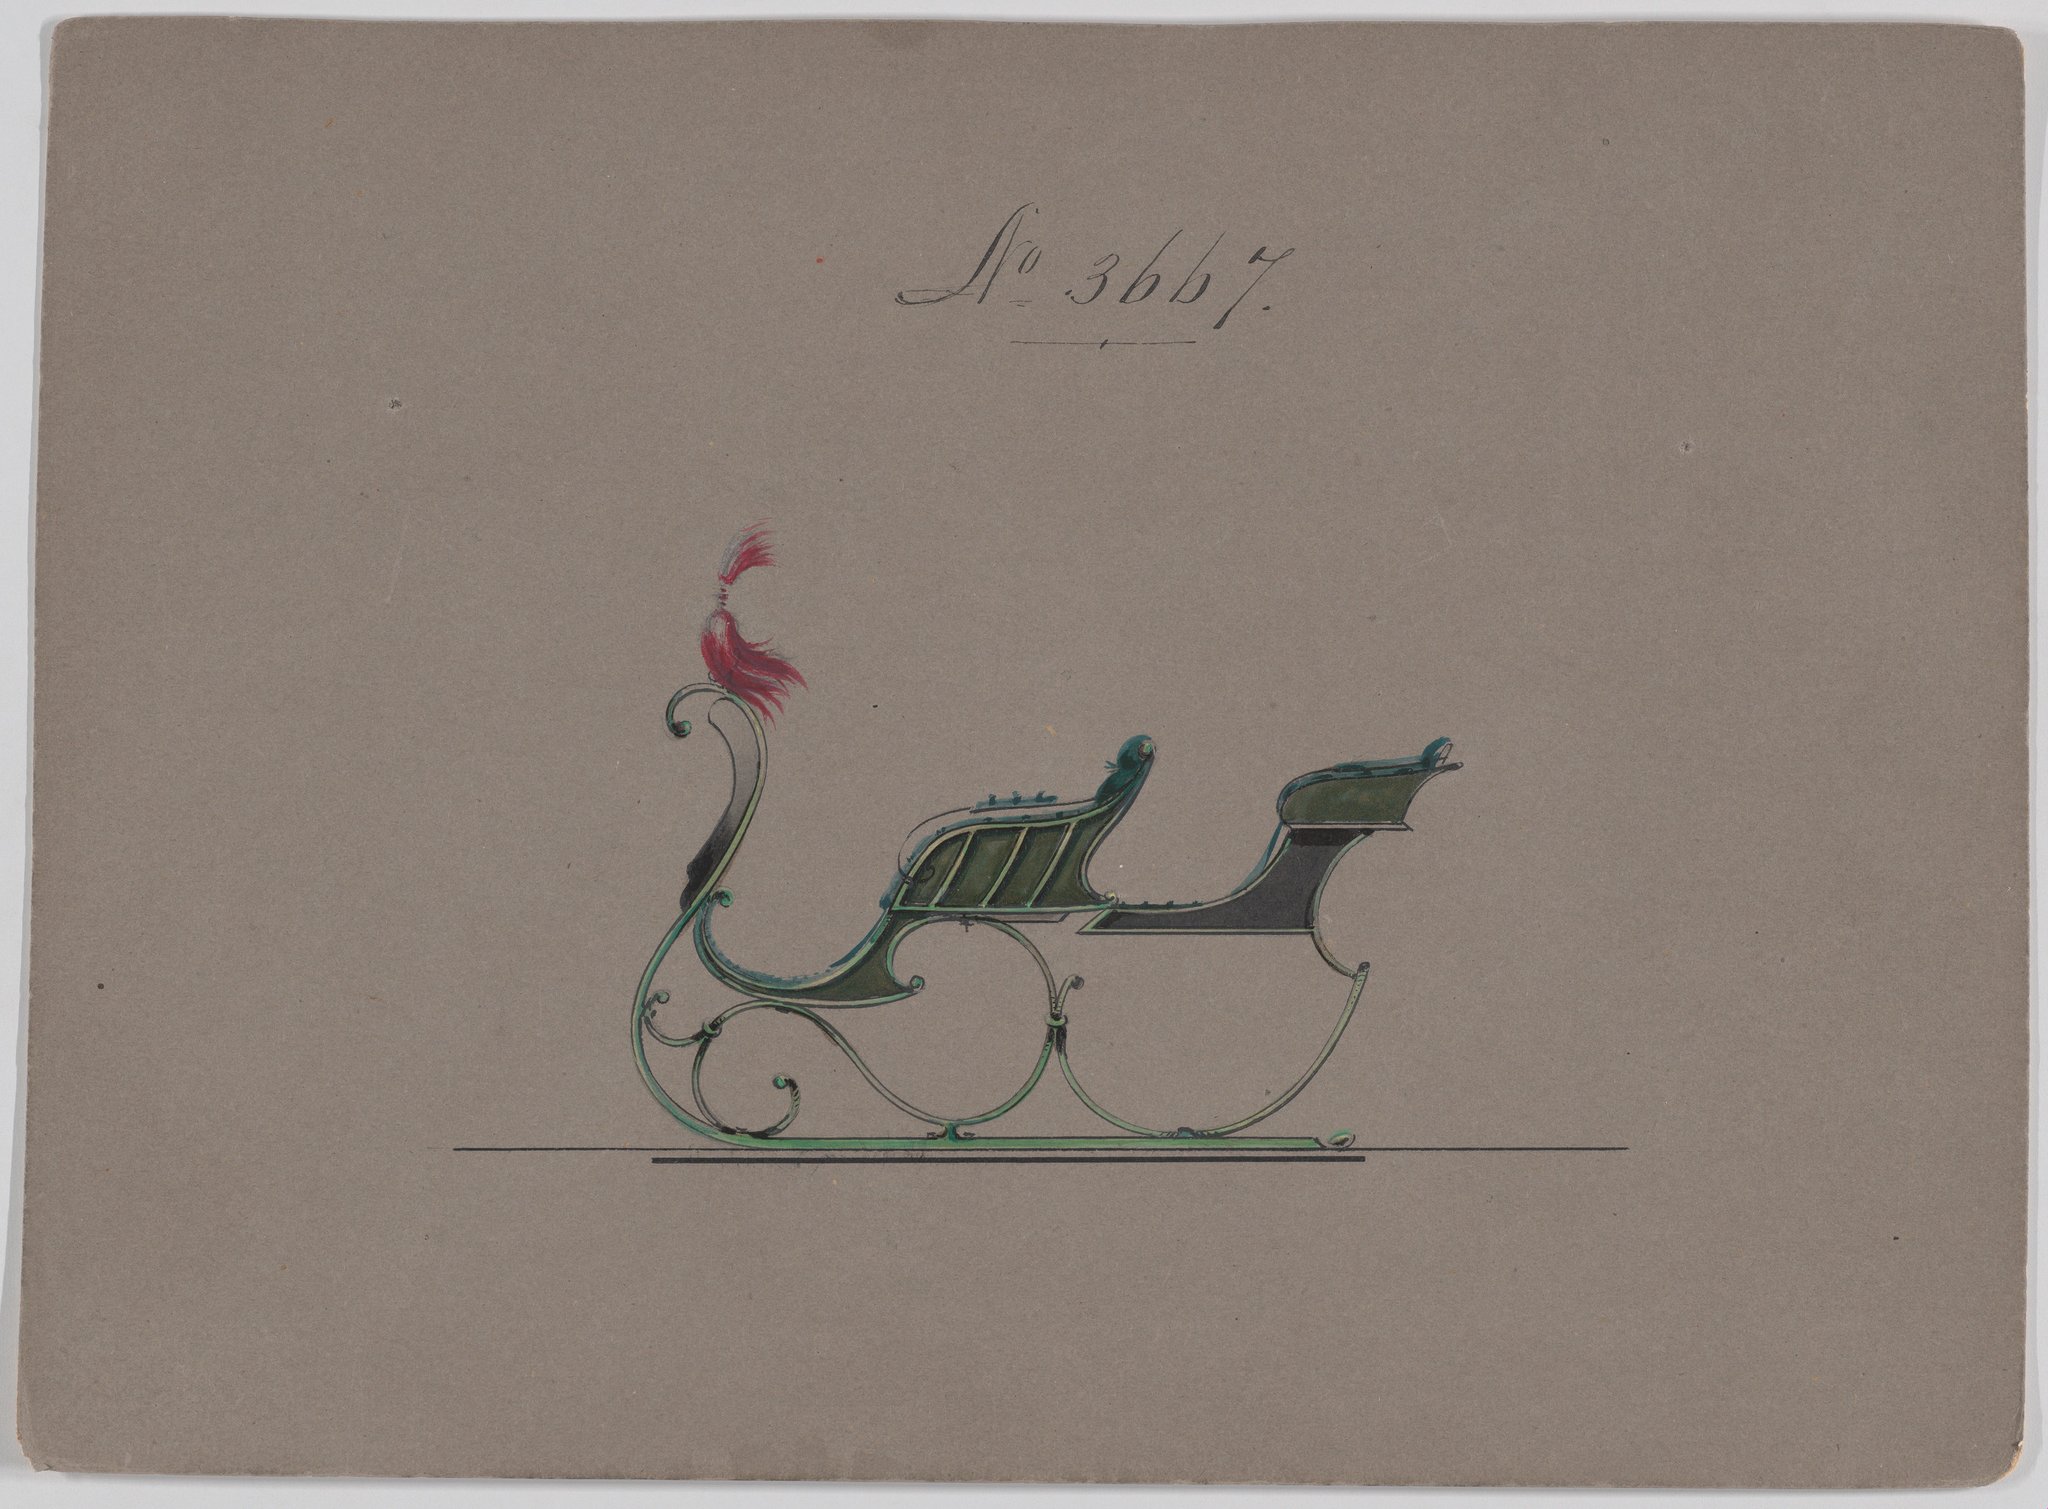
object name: drawing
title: Sleigh with Rumble Seat # 3667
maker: brewster & co.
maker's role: manufacturer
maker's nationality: american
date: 1881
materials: gouache, gum arabic, ink, watercolor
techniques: pen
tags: sleighs